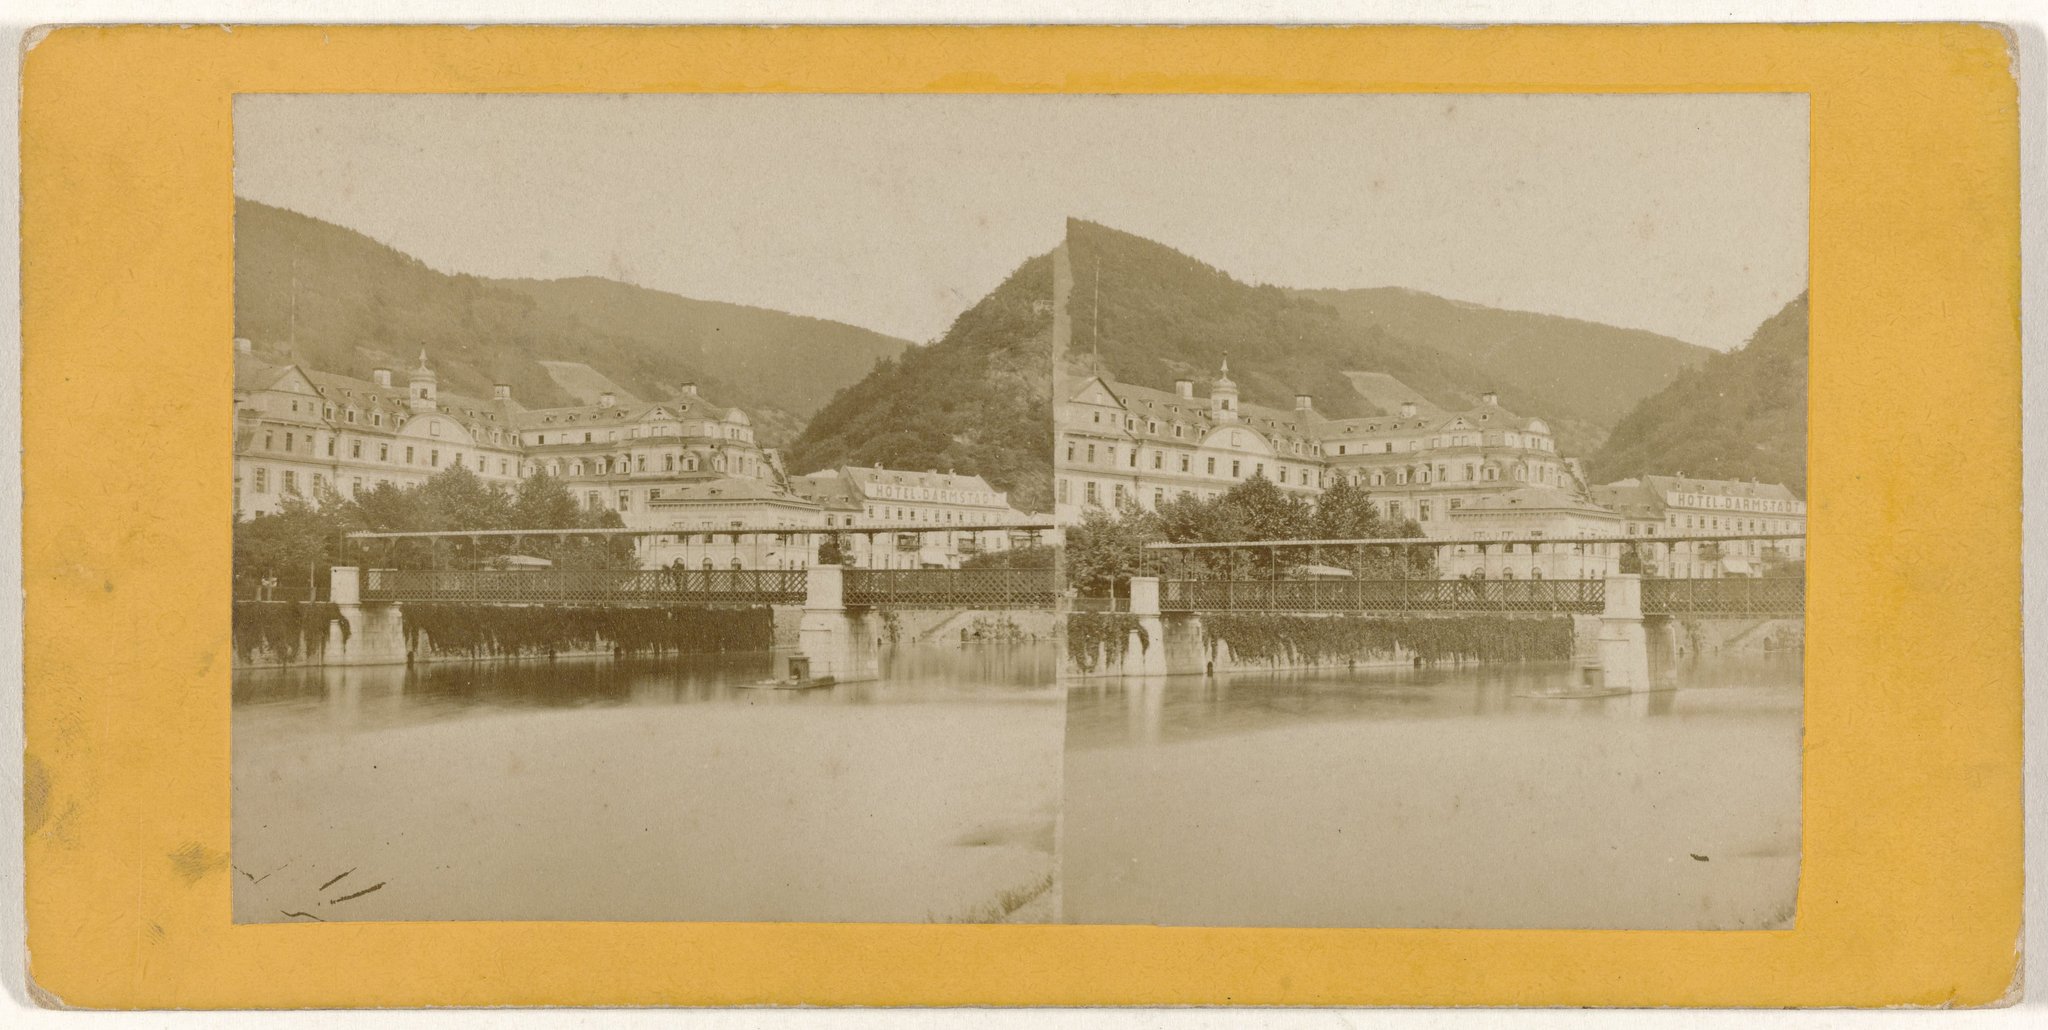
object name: stereograph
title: Brug over de Lahn in Bad Ems, Duitsland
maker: Anonymous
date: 1852-1863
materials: cardboard, paper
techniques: albumen print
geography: bad ems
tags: dale, valley, village, bridge in city across river, canal, etc.